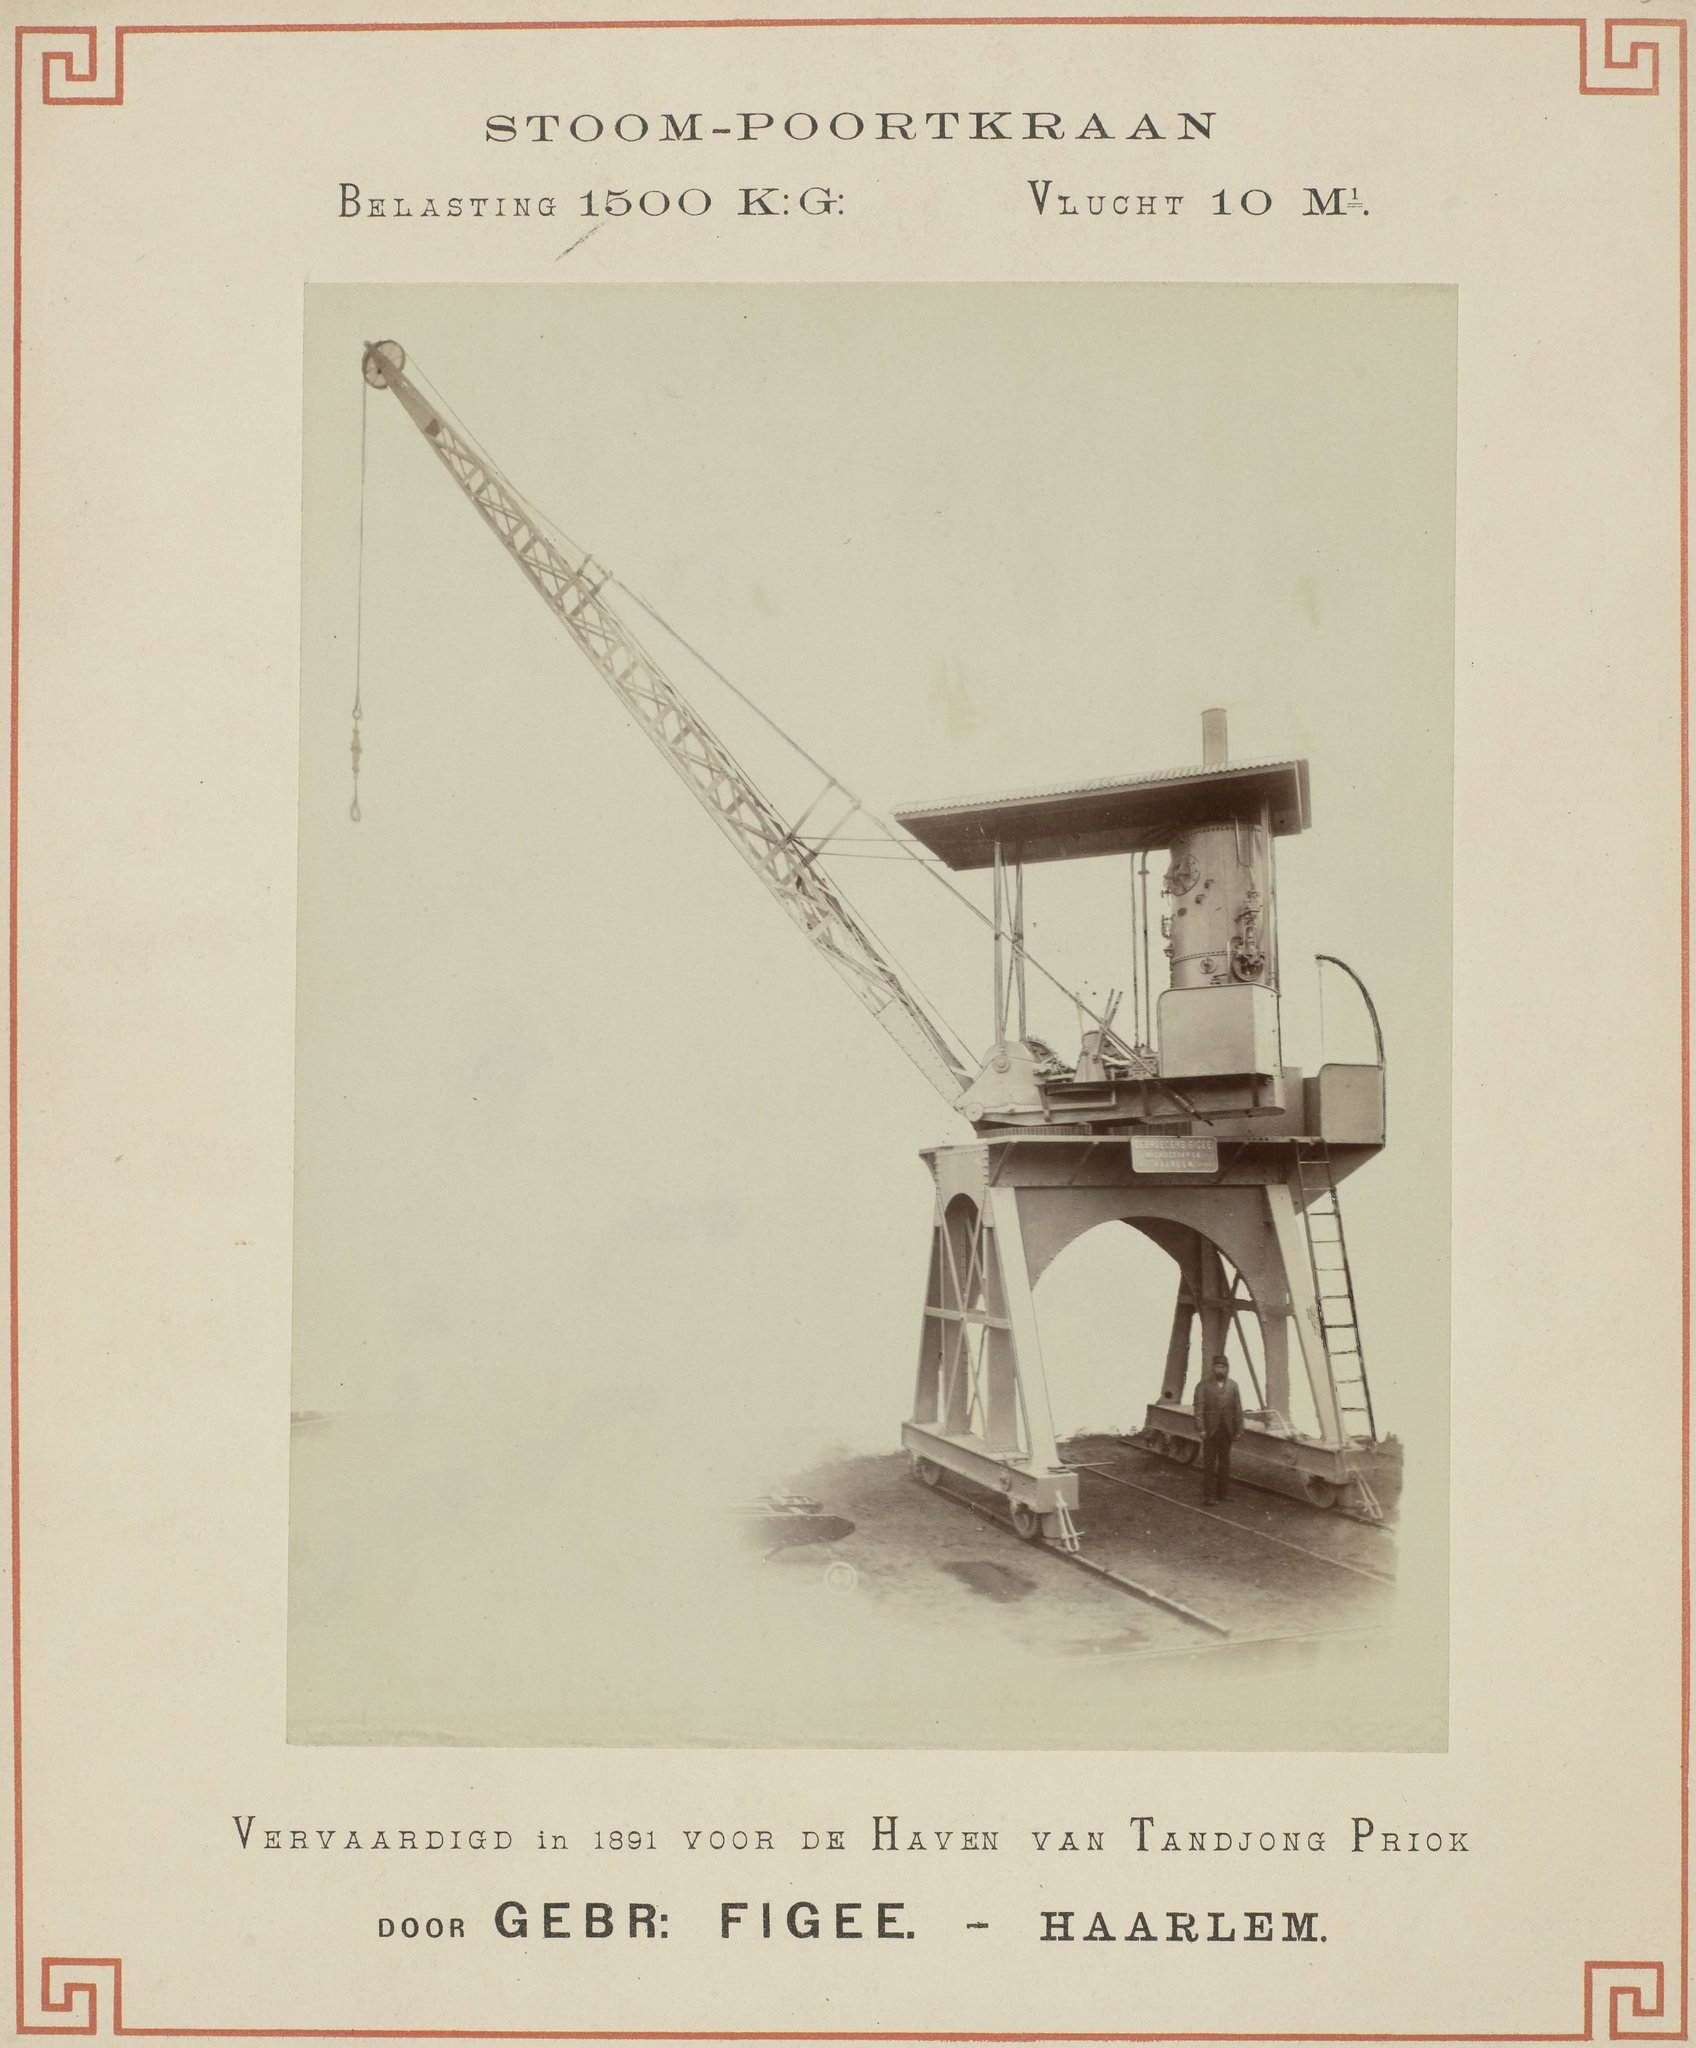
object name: photograph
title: Stoompoortkraan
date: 1891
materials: cardboard, paper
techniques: photography, printing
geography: haarlem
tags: indië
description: Foto van een kraan, op karton geplakt, in rood gelijnd kader met tekst onder en boven waarop opdrachtgever e.d. Vervaardigd voor de Haven van Tandjong Priok. Opschrift; b. en o.: 'Gebr. Figee - Haarlem - Holland'.